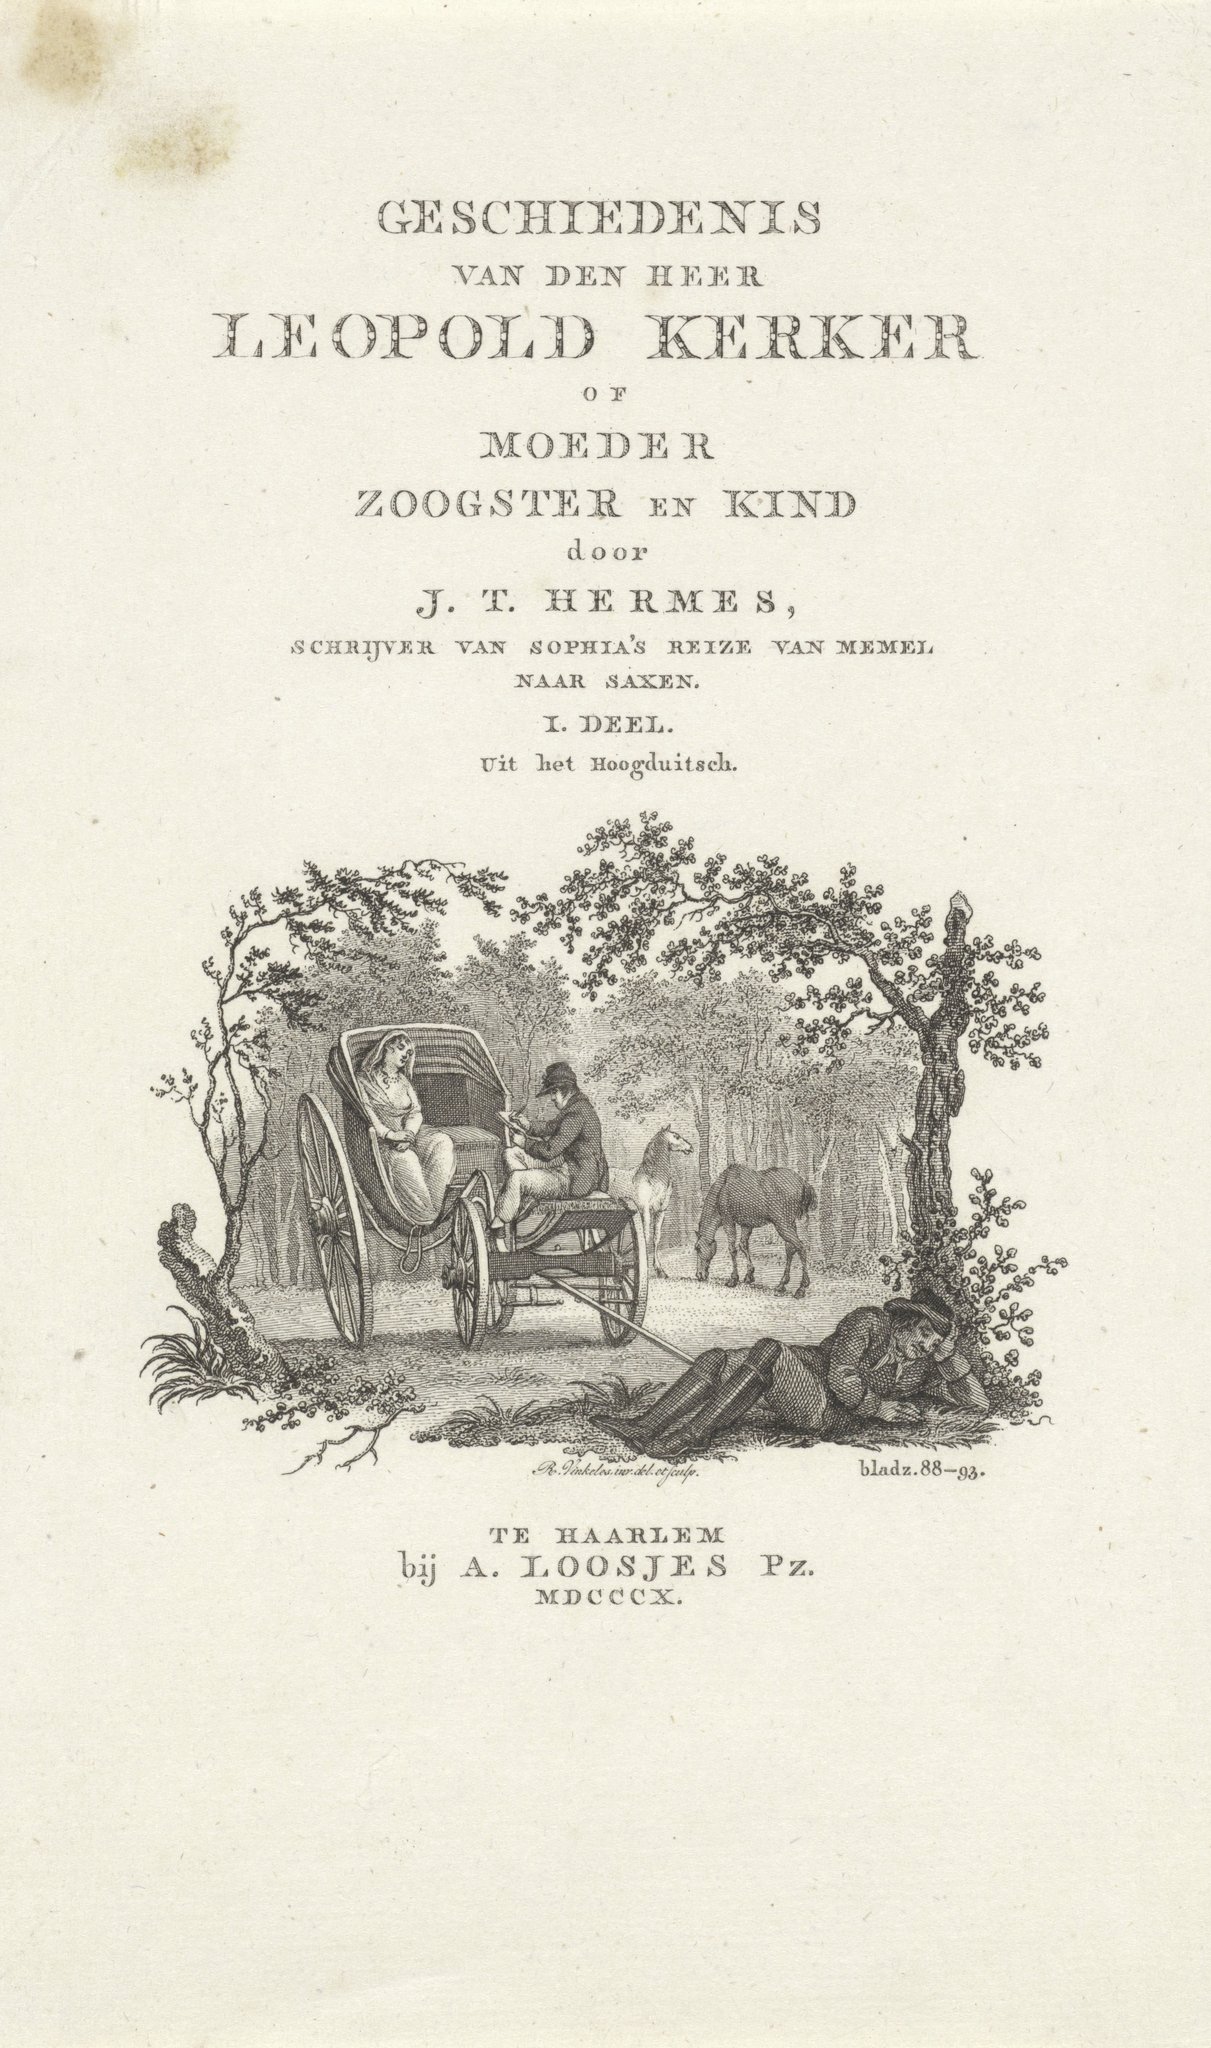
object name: titelblad, titelpagina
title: Titelpagina: J.T. Hermes, 'Geschiedenis van den heer Leopold Kerker of Moeder Zoogster en Kind', 1810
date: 1810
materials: paper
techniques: engraving, etching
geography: haarlem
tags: art (+ working from live model), forest, wood, horse, four-wheeled vehicle drawn by two animals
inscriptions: collector's mark: Lugt 2228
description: Titelpagina voor: Hermes, Johann Timotheus. Geschiedenis van den heer Leopold Kerker of Moeder Zoogster en Kind. Haarlem: Adriaan Pietersz. Loosjes, 1810.